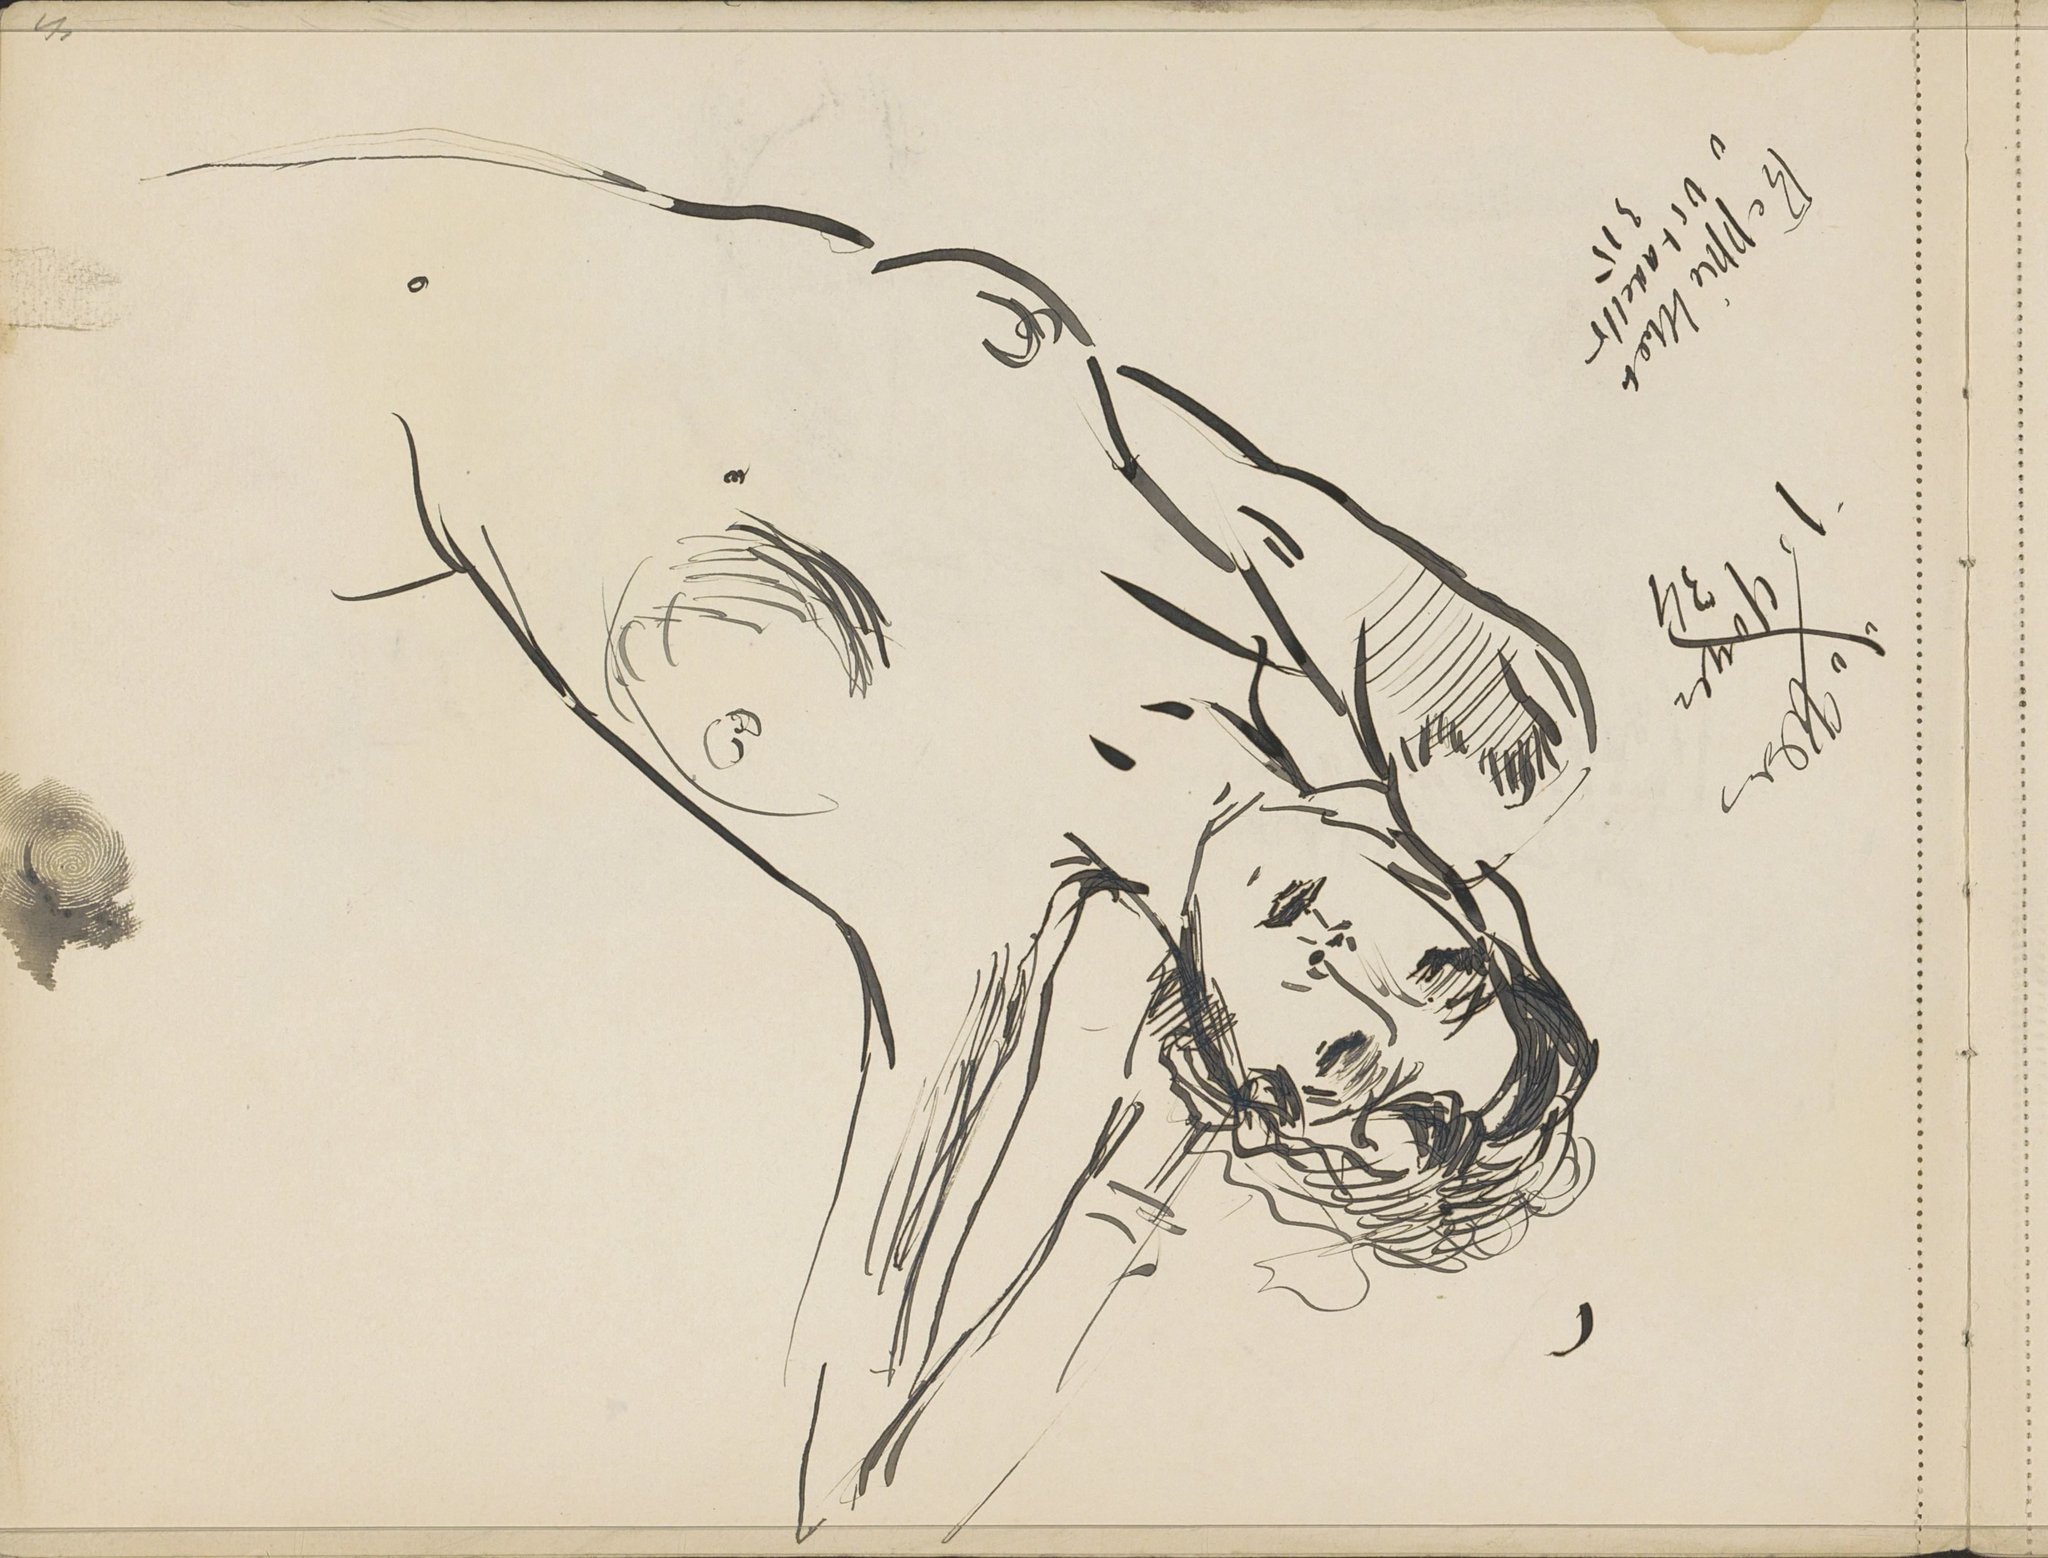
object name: sketchbook leaf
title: Vrouwelijk naakt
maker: isaac israels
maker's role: draughtsman, painter, print maker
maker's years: 1865-1934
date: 1875-1934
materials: ink, paper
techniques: pen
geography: the hague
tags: the (nude) human figure; 'corpo humano' (ripa) - aa - female human figure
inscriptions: annotation: ‘[doorgestreept] / Beppie Wels[?] / v Ostadestr / 315’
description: Haar handen achter haar hoofd. Blad 1 verso uit schetsboek XXIII met 20 bladen.